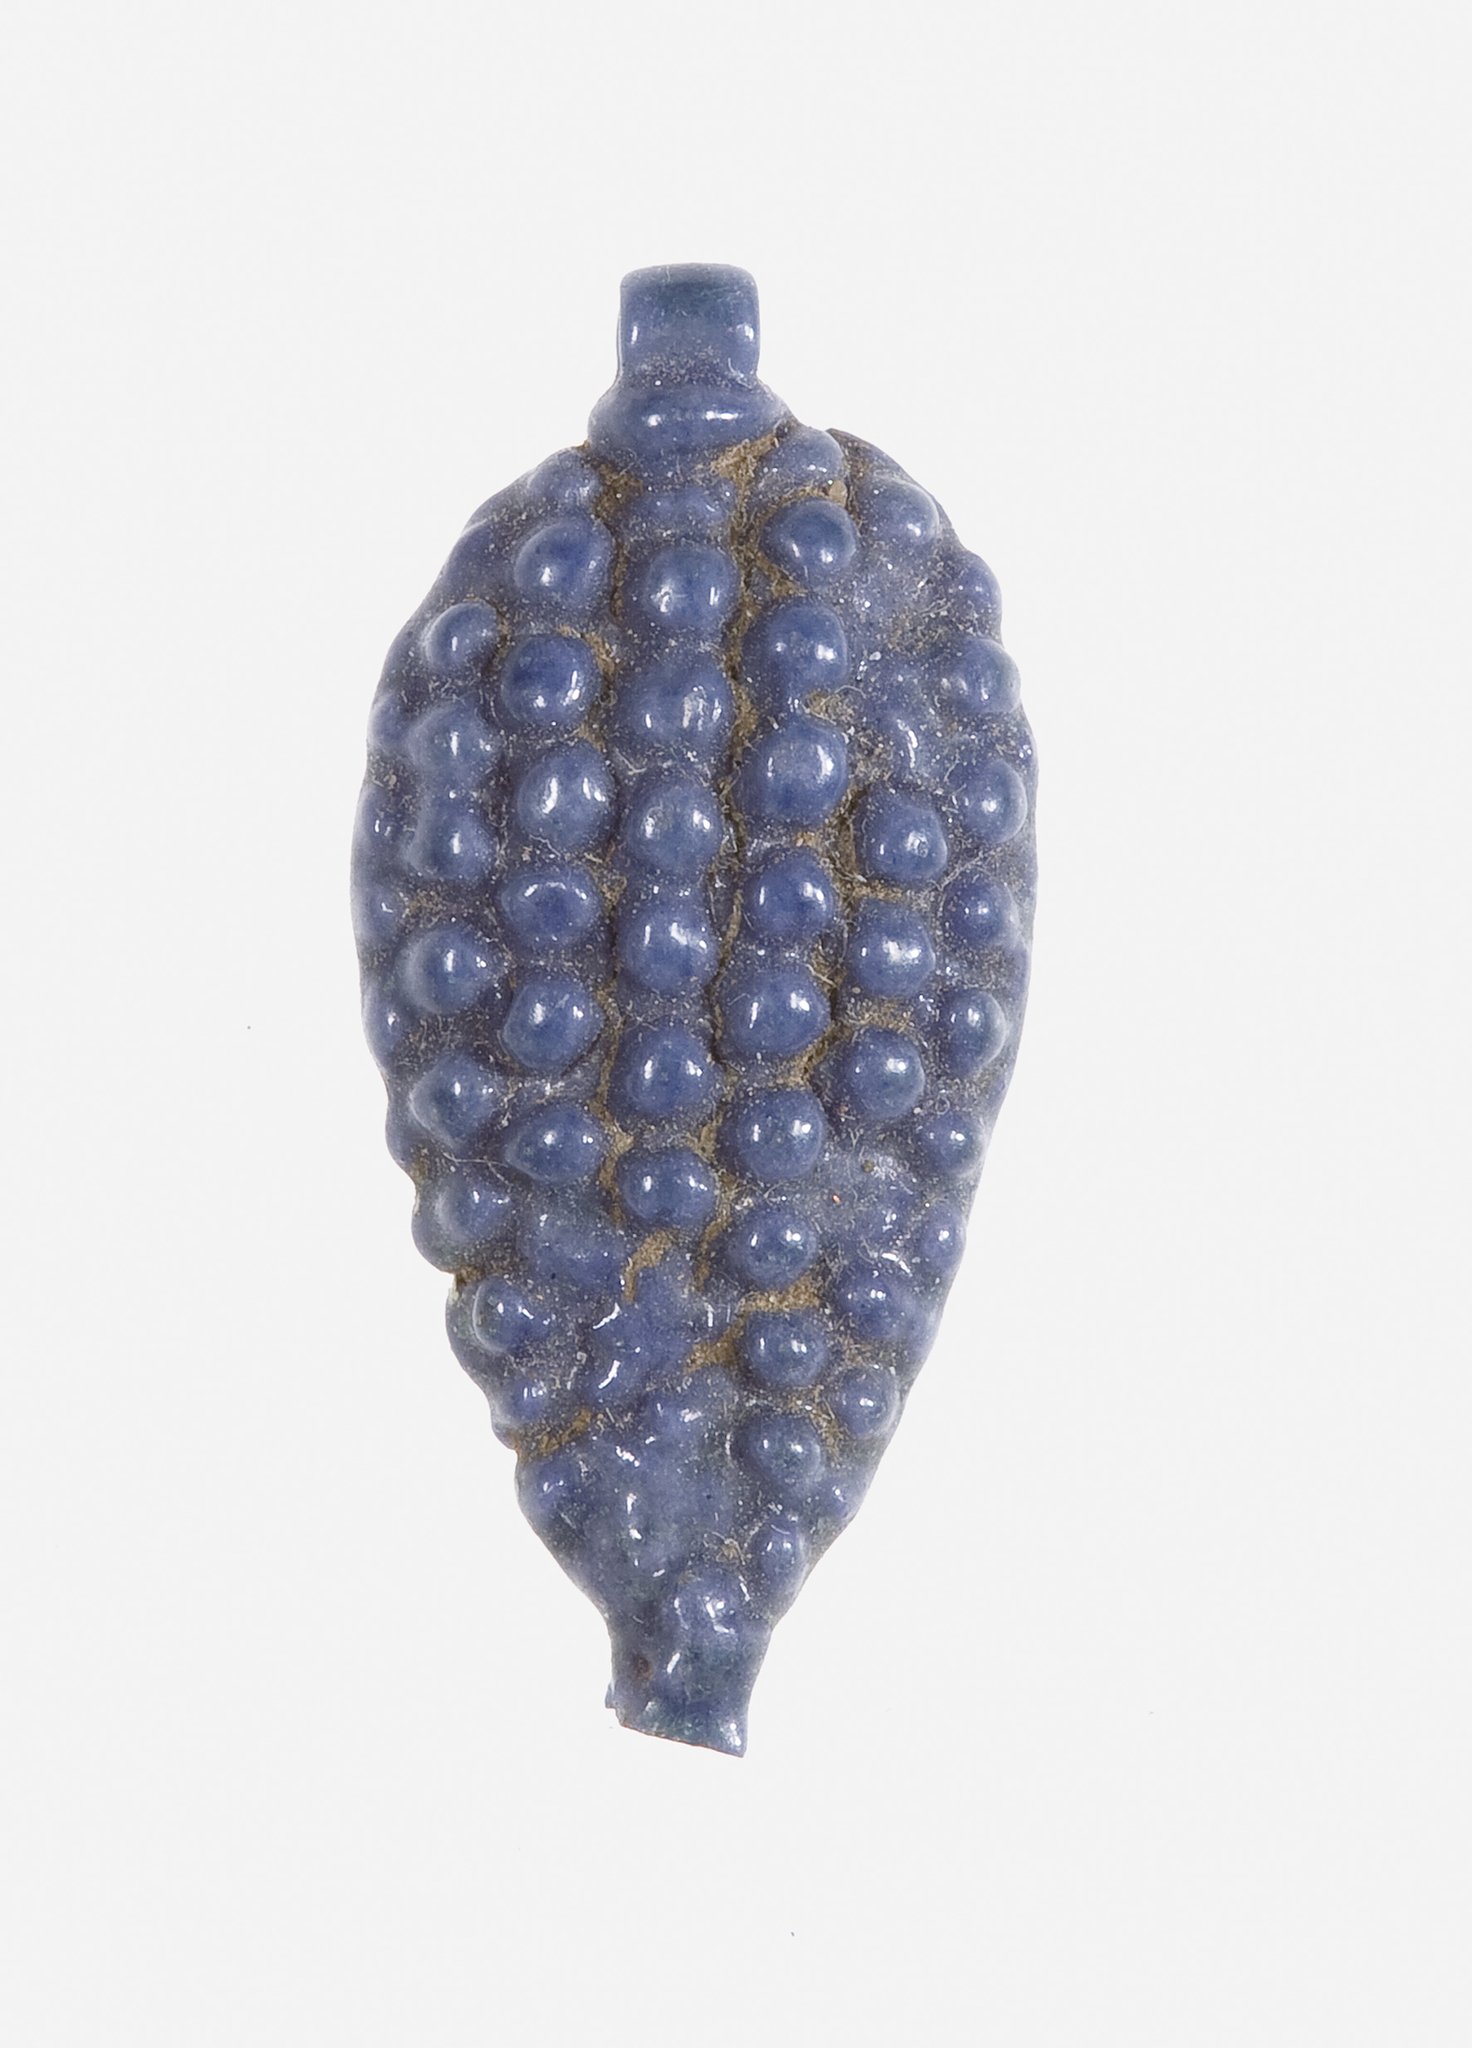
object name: pendant, grape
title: Pendant: Bunch of Grapes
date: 1390-1352 BCE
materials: faience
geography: egypt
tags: grapes